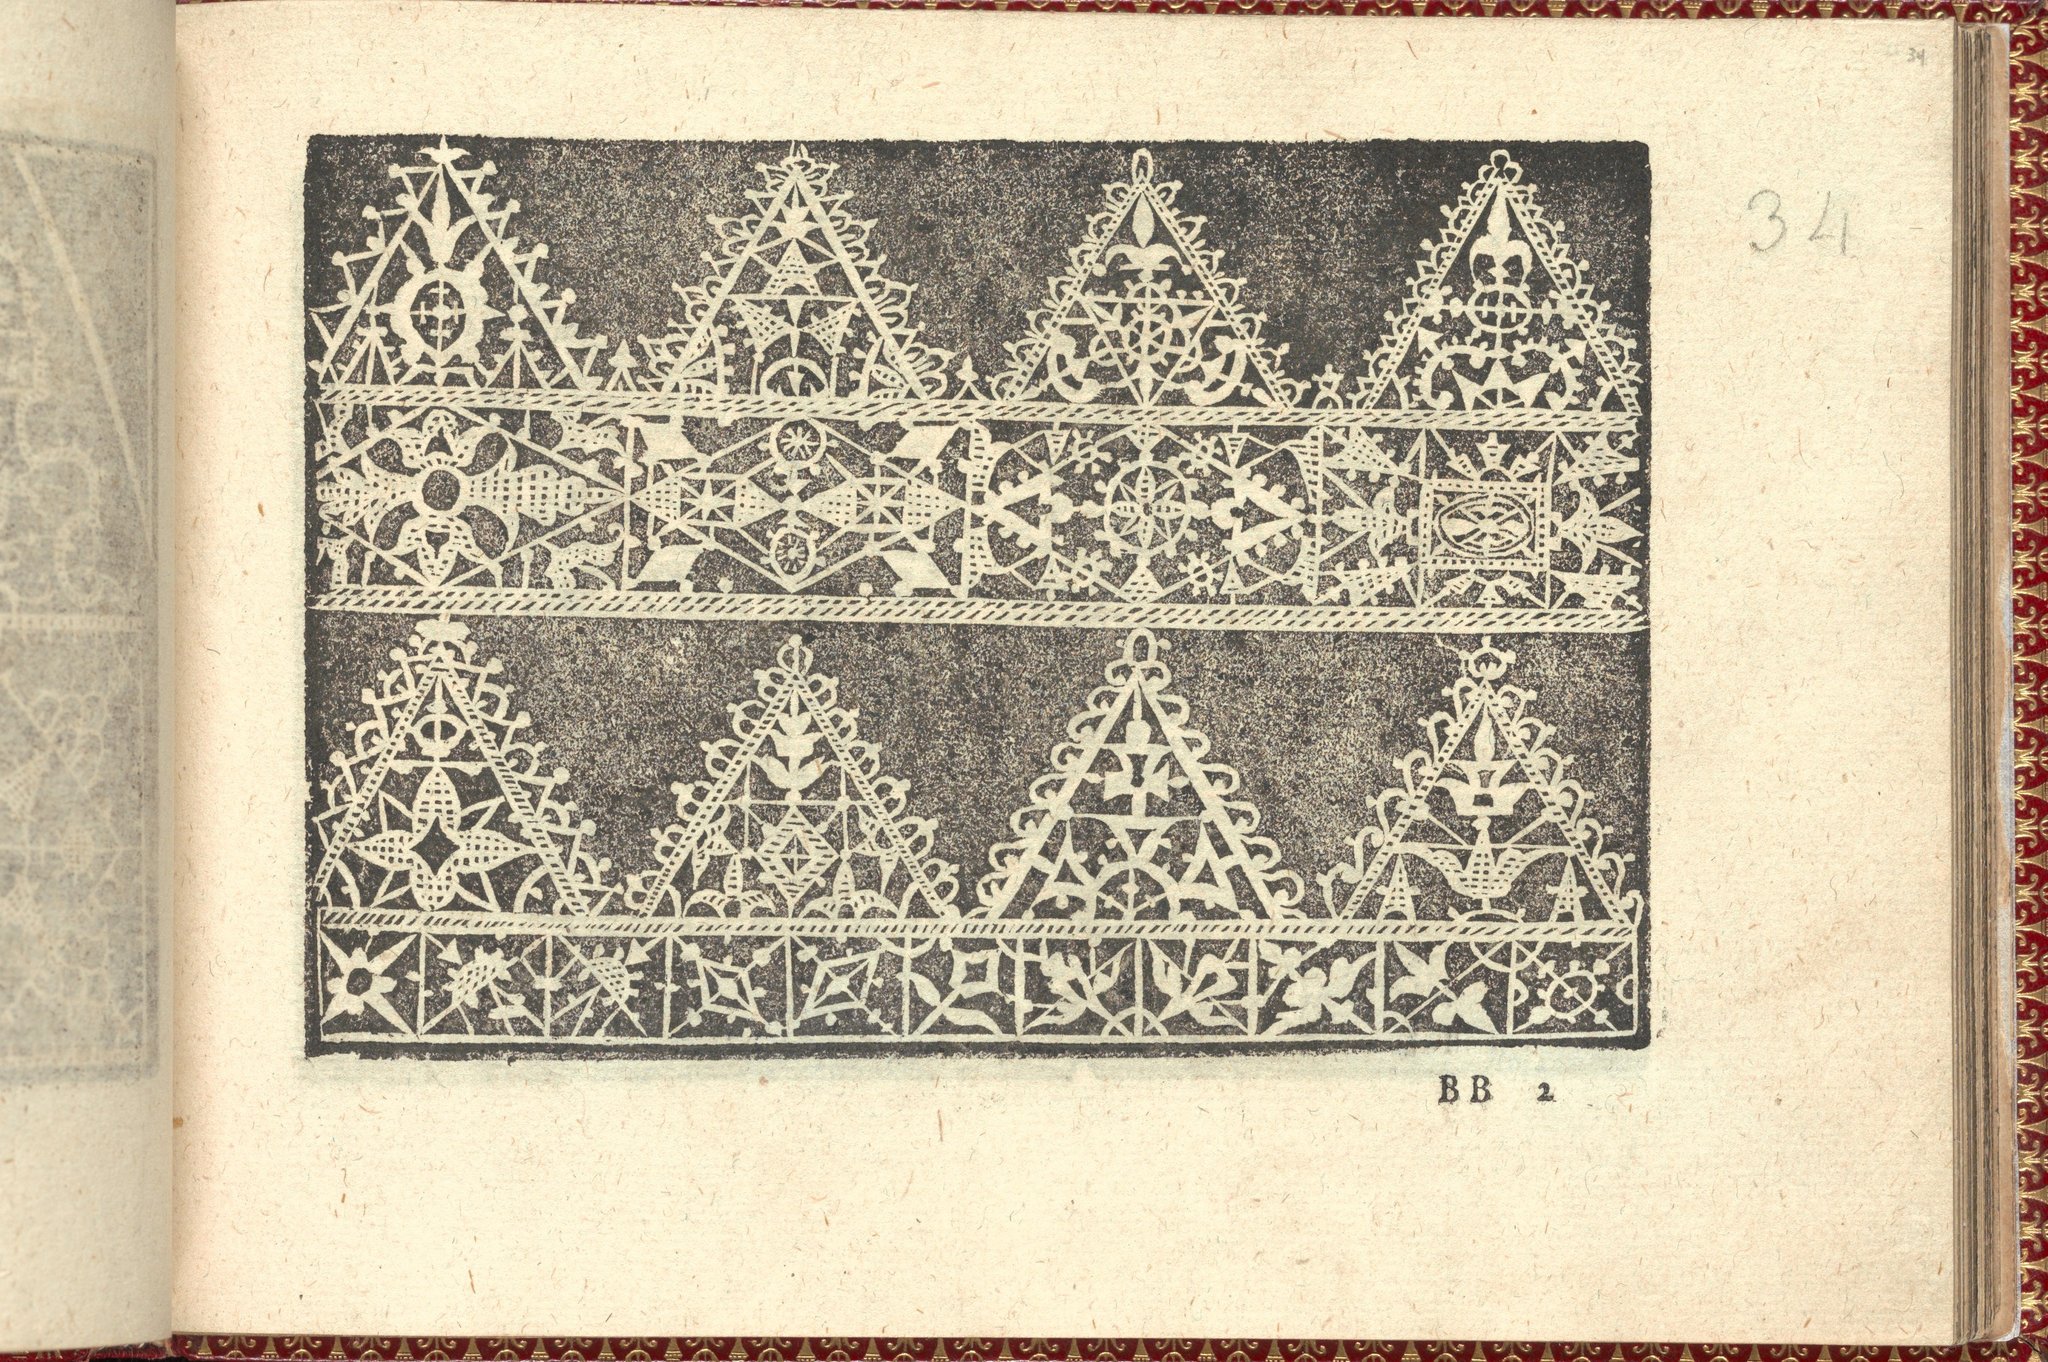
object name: book print ornament architecture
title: Corona delle Nobili et Virtuose Donne: Libro I-IV, page 34 (recto)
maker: cesare vecellio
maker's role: publisher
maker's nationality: italian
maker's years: 1521-1601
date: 1601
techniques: woodcut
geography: italy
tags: ornament